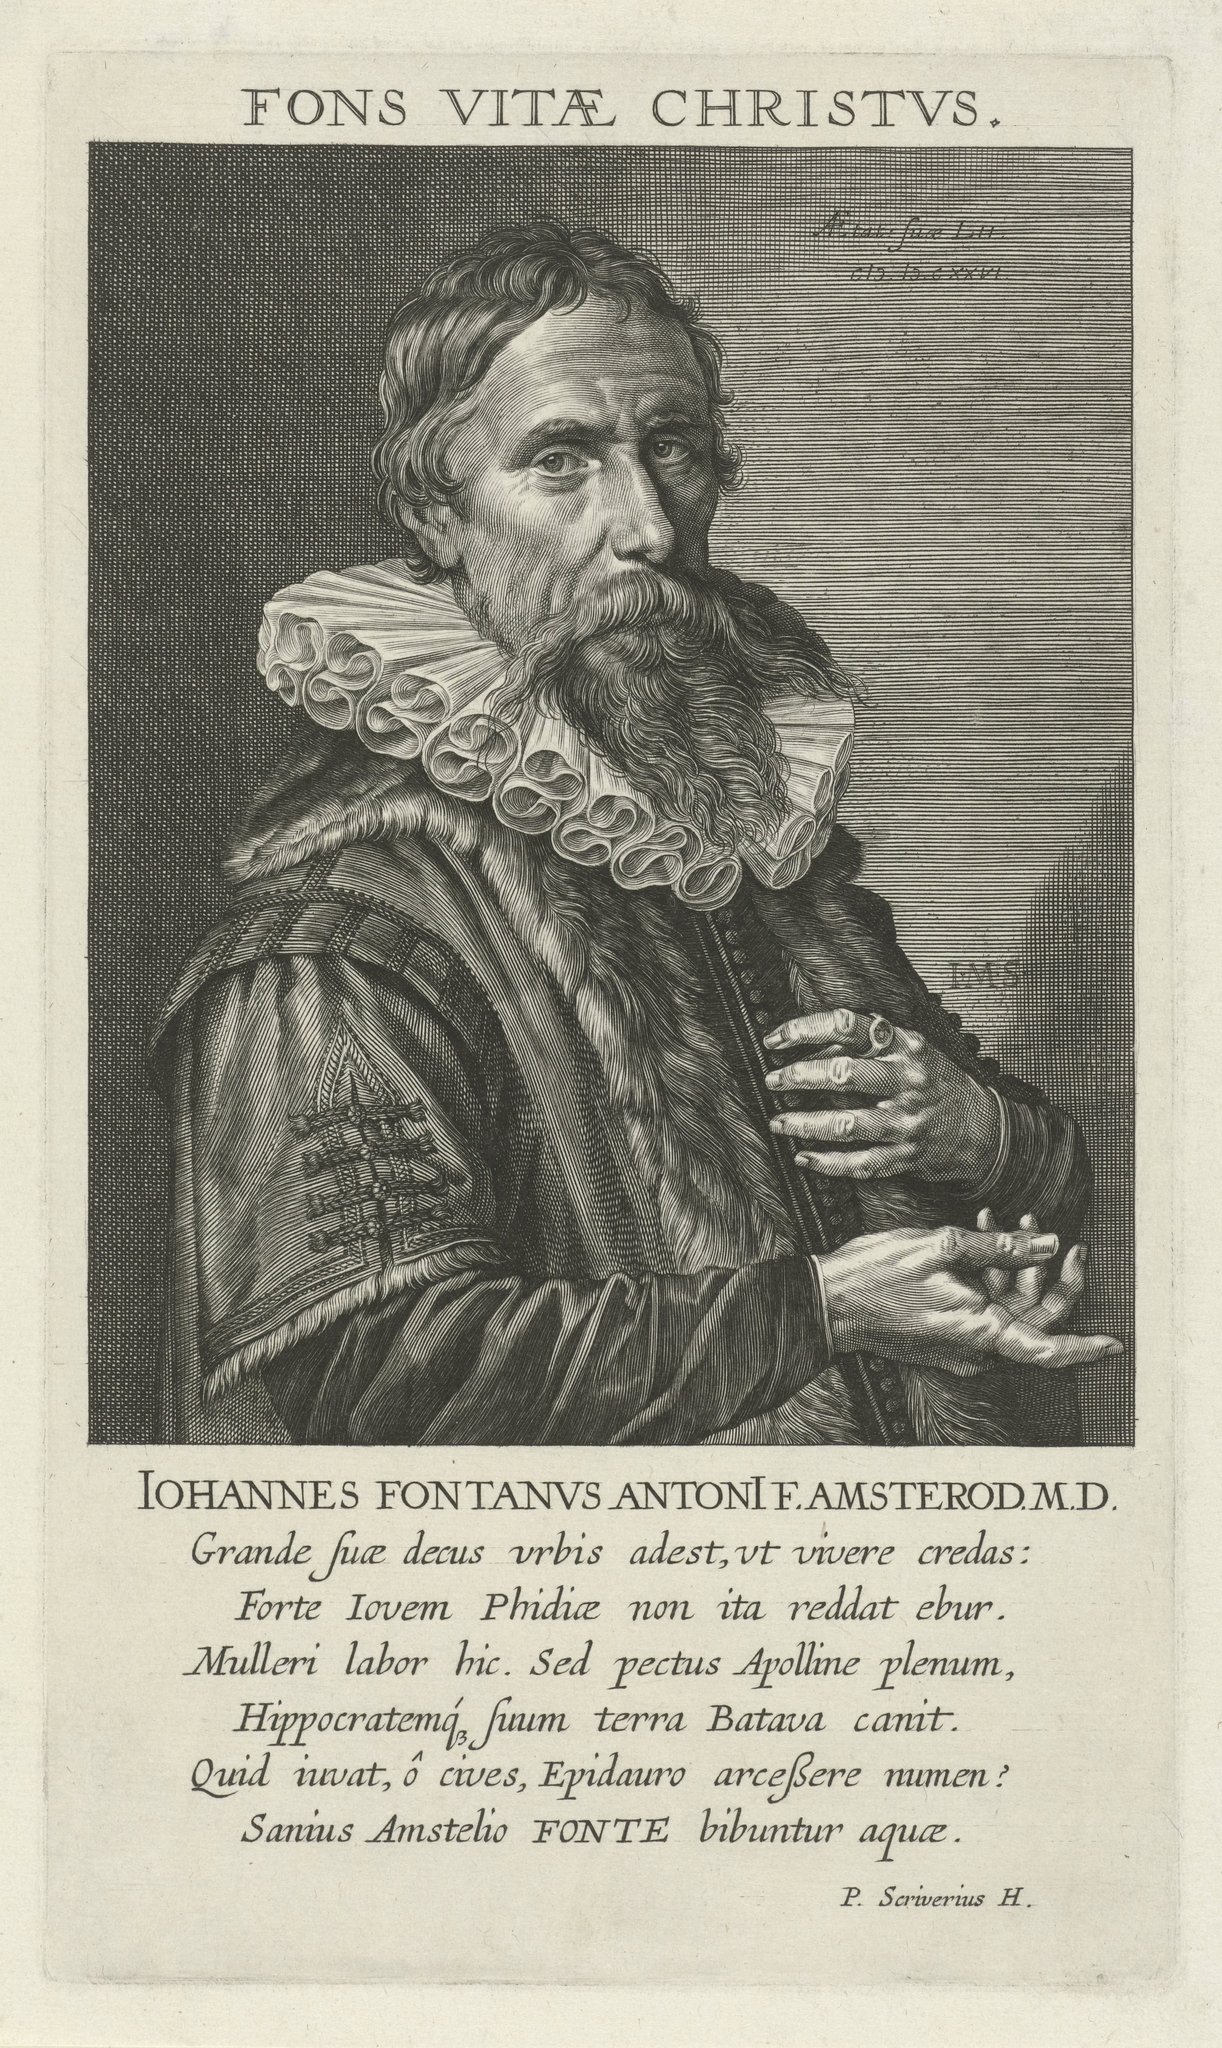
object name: print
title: Portret van Johan Fonteyn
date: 1626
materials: paper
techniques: engraving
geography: amsterdam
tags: amsterdam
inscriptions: collector's mark: Lugt 2165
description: Portret van Johan Fonteyn, arts te Amsterdam, op 52-jarige leeftijd. Onderaan in de marge een zesregelig vers in het Latijn.